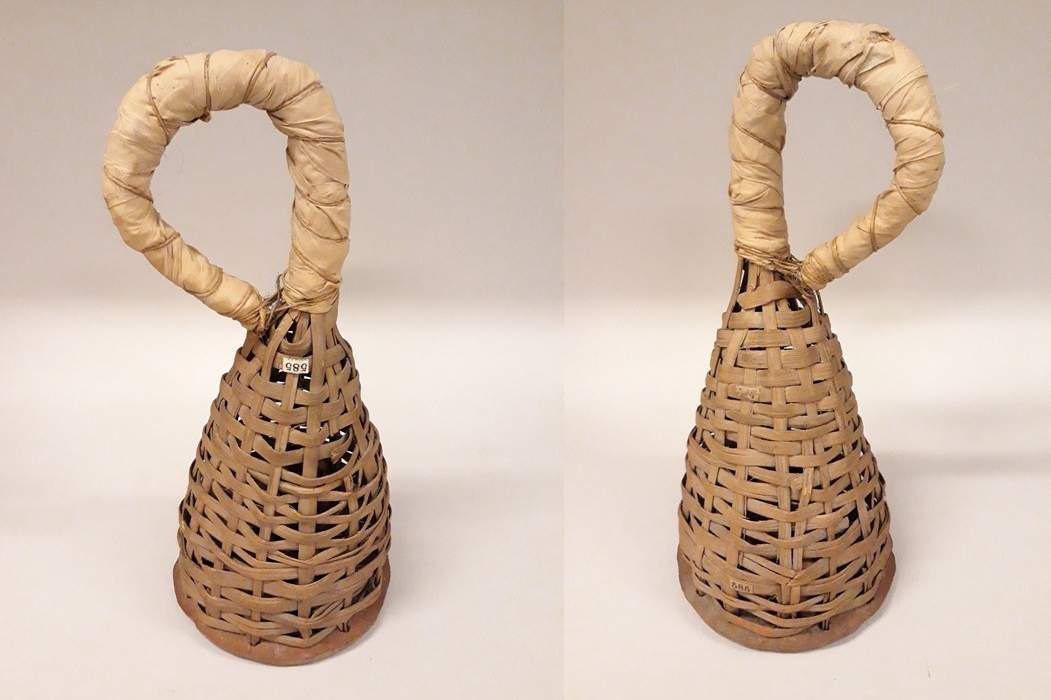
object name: cacha rattle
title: Cacha (rattle)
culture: cuban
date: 1867-1900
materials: textile, wood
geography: cuba